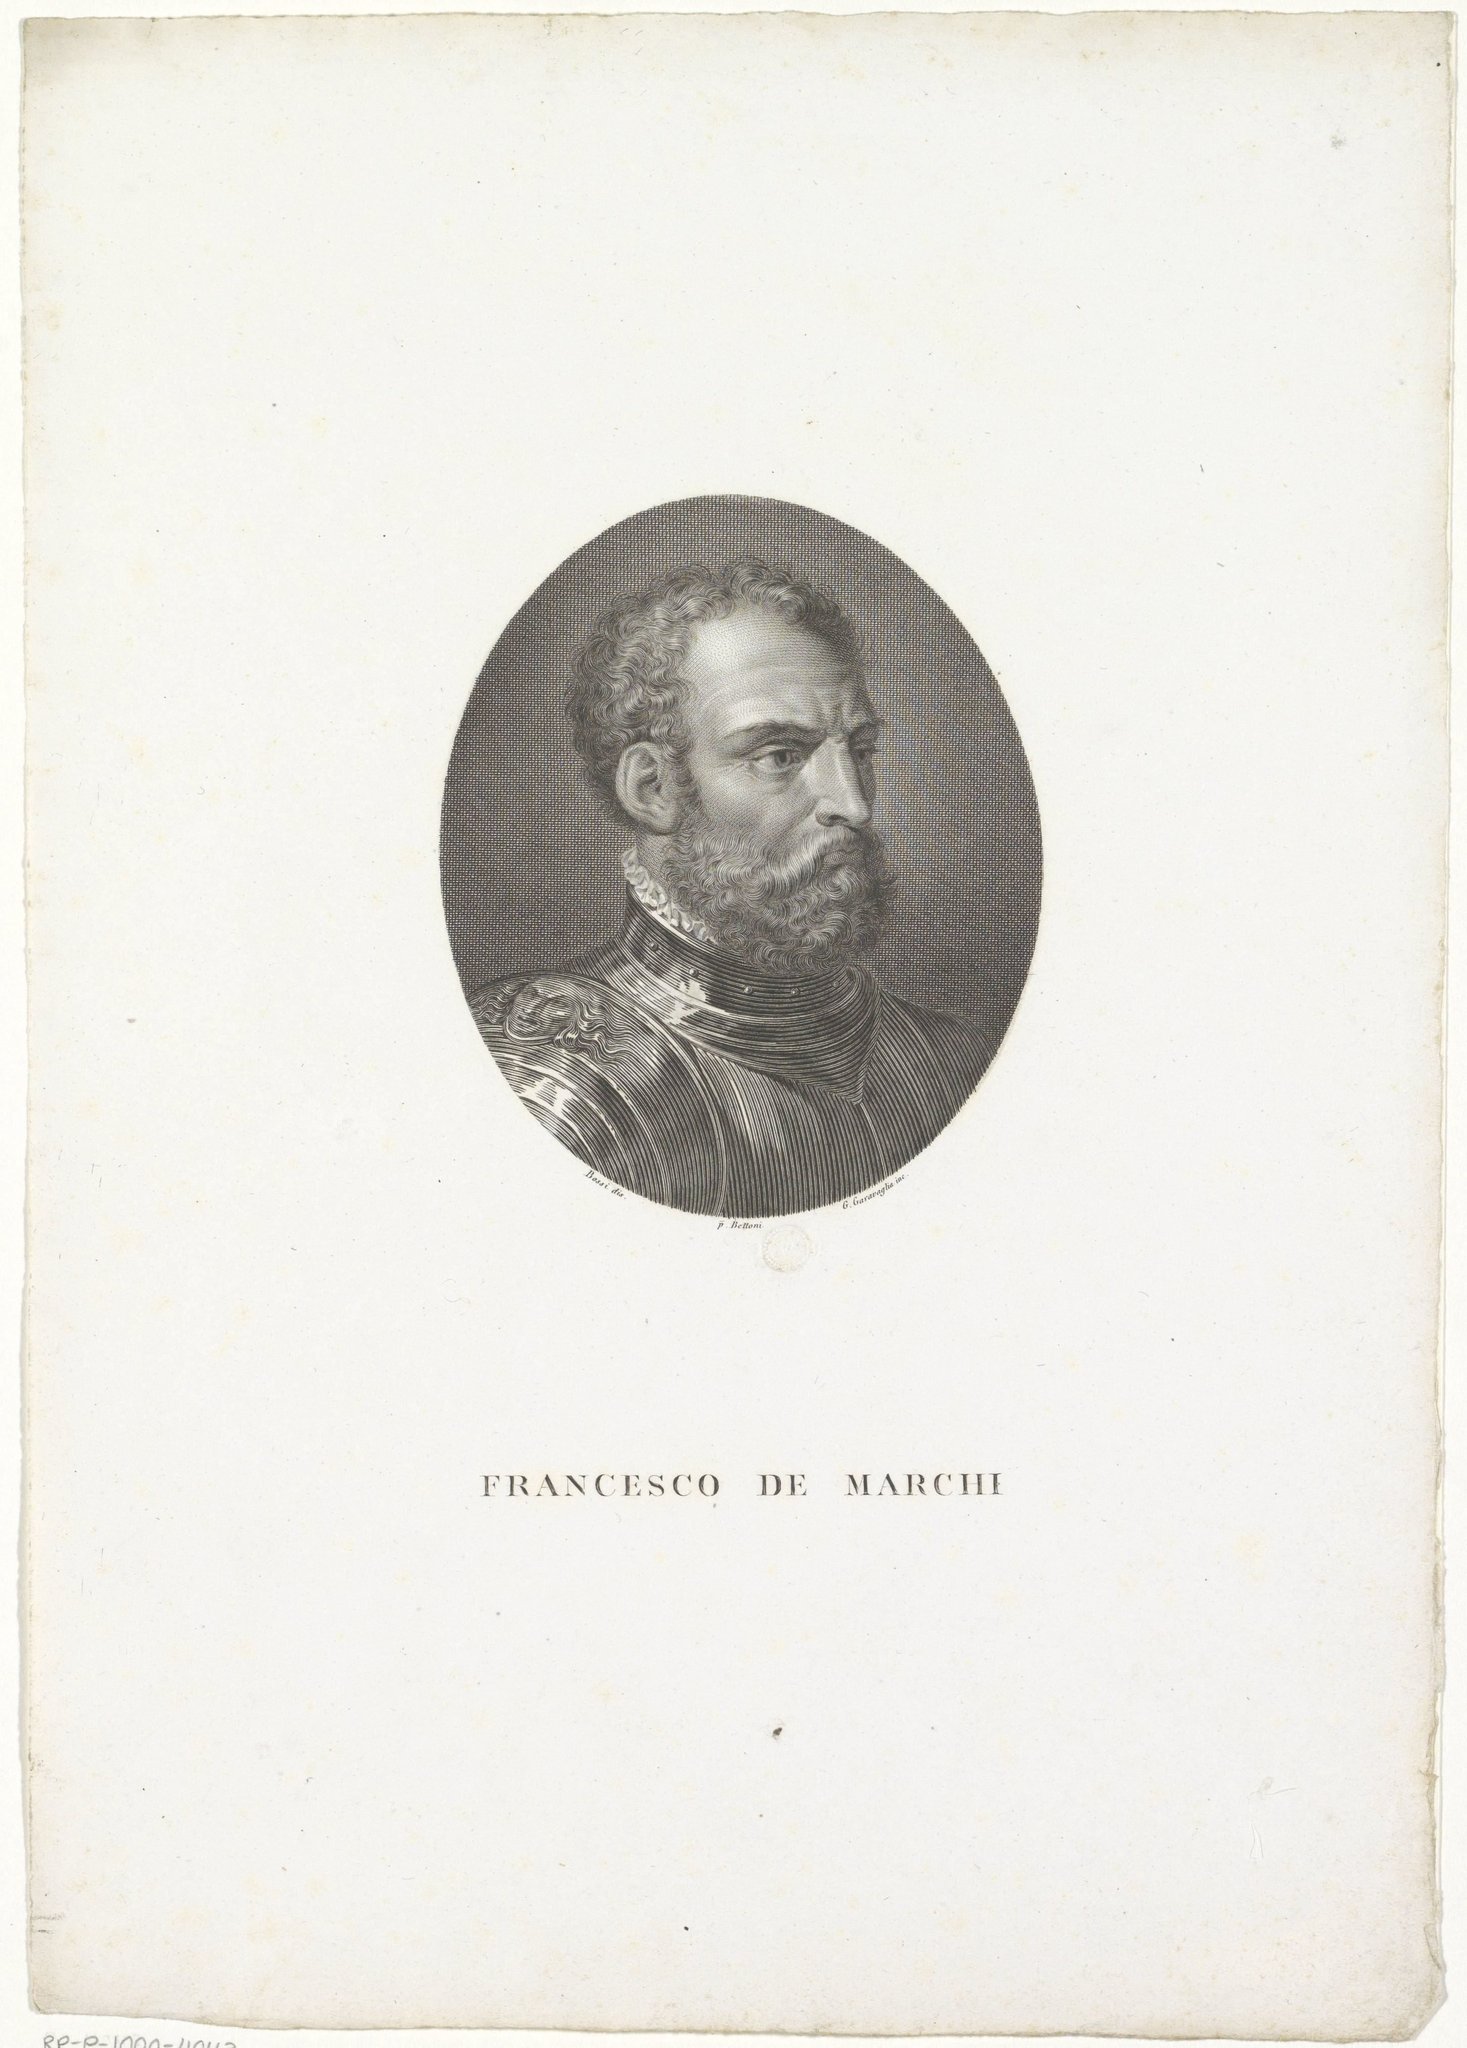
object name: print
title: Portretten van beroemde Italianen in ovalen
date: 1800-1835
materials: paper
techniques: engraving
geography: italy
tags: engineer, historical persons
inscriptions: collector's mark: Lugt 2228, collector's mark: Lugt 4187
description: Deze prent maakt deel uit van een reeks portretprenten van onbekende omvang. De reeks is in meerdere staten uitgegeven. De eerste staat met enkel het portret in ovaal. Een tweede staat met naam van de geportretteerde in holle letters onder de voorstelling. Een derde staat met de naam van de geportretteerde in gevulde letters onder de voorstelling. En een vierde staat met een rechthoekig kader rondom het ovale portret.